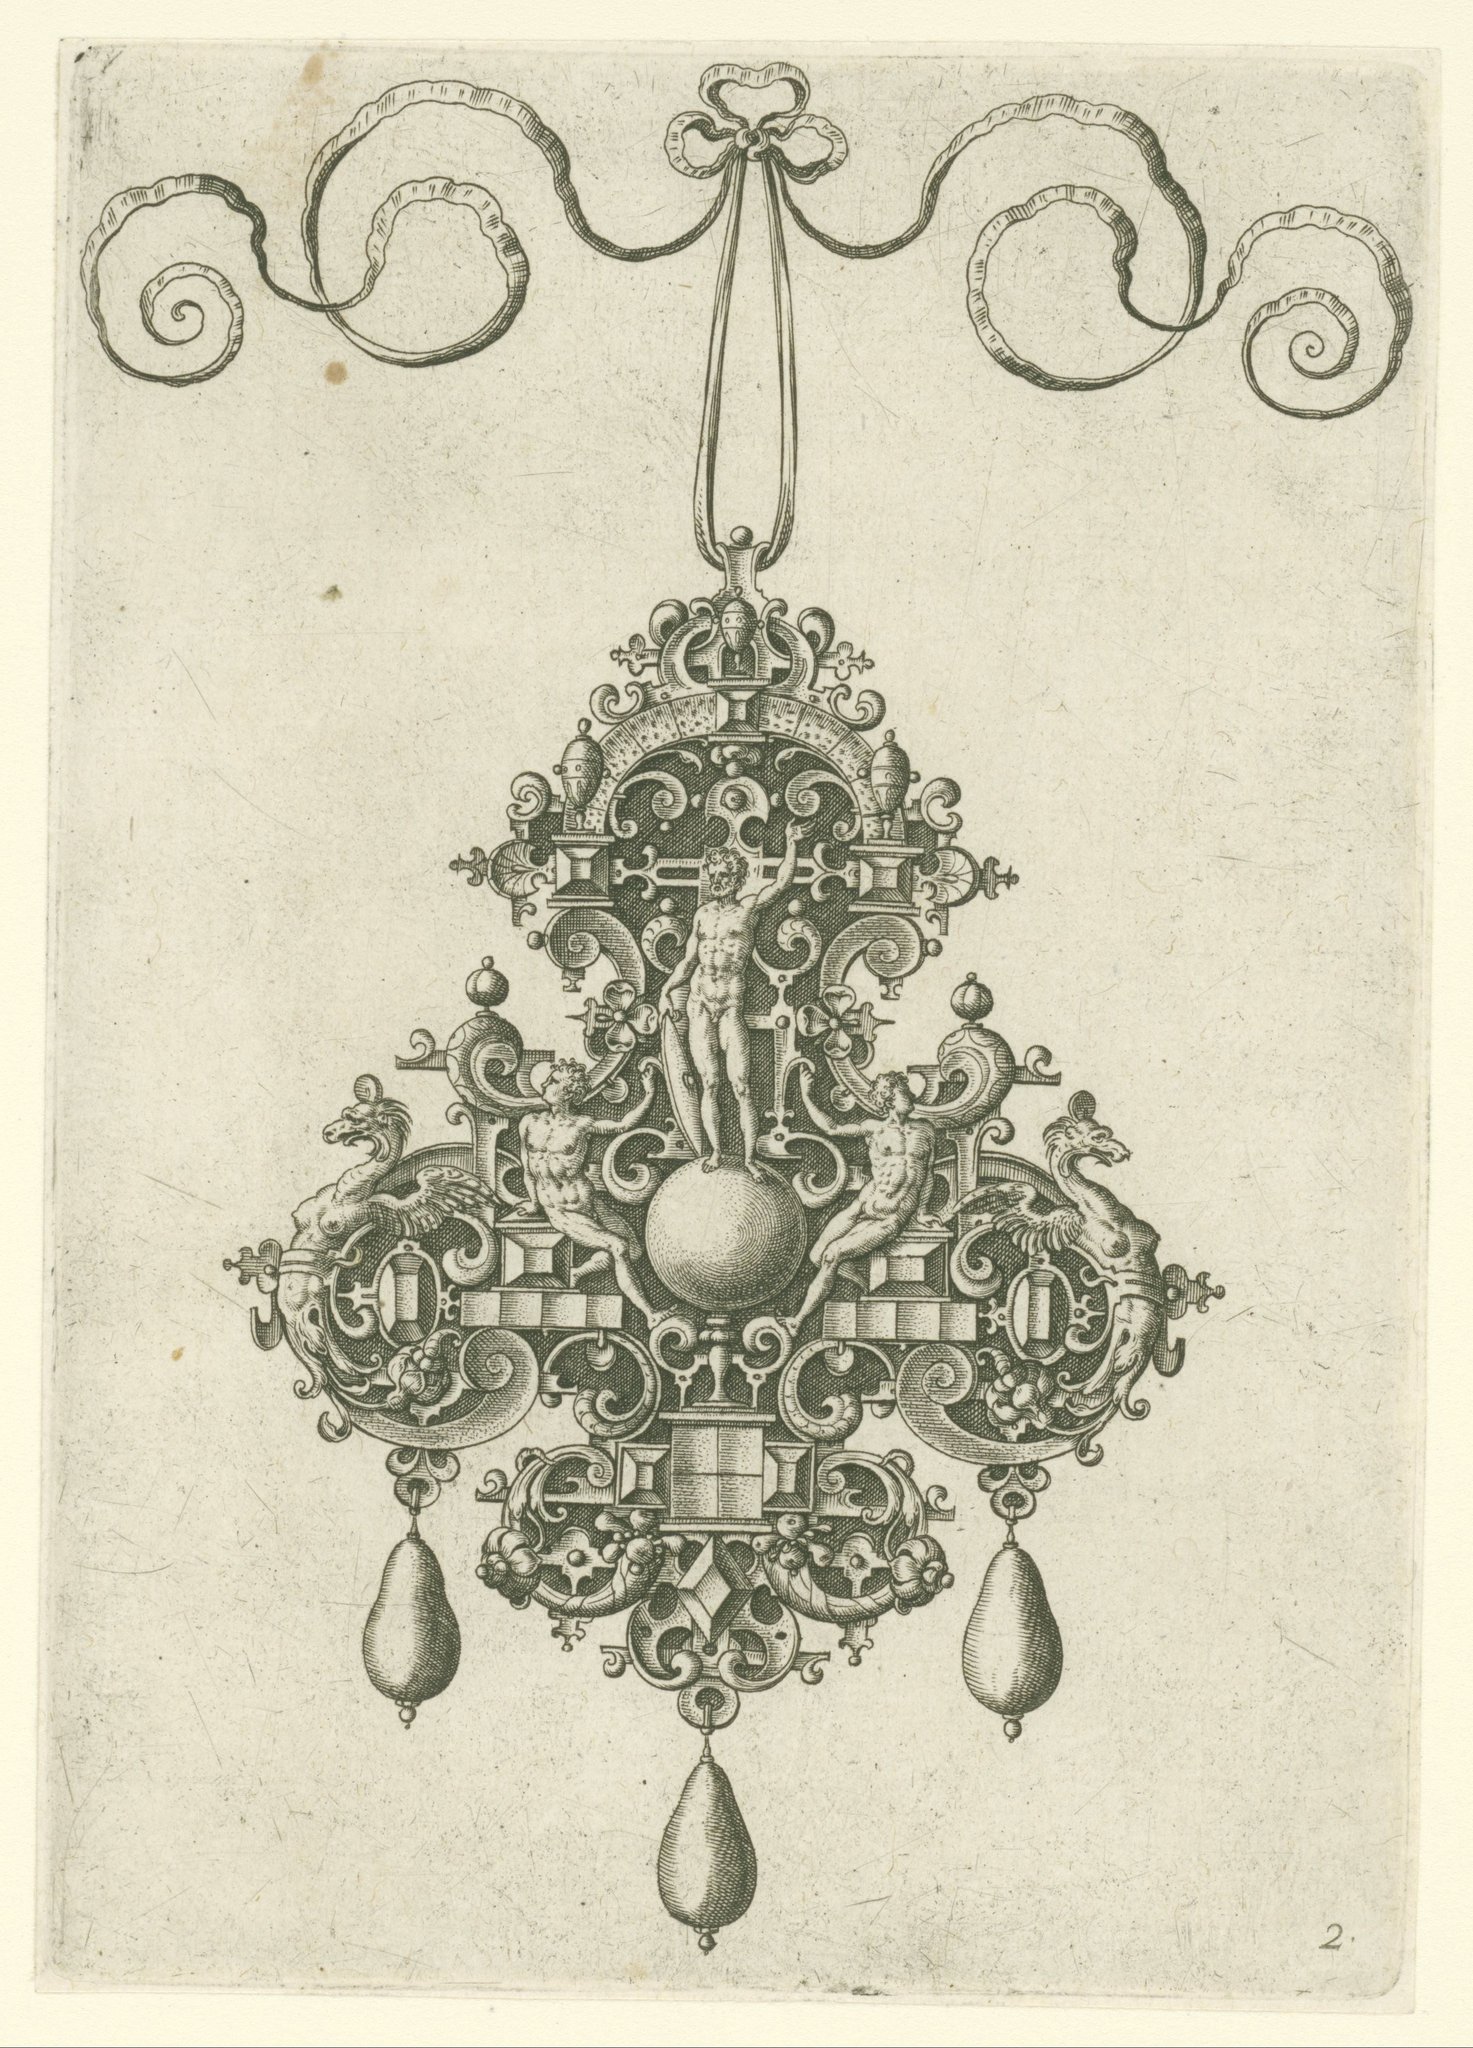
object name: ornament print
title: Voorzijde van hanger met naakte godheid met schild, zittend op een bol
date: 1581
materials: paper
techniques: engraving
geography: netherlands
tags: pendant, trinket, 'breloque'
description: No. 2 uit serie van 10 bladen met voorzijden van hangers. Edelstenen in zettingen van grotesken en rolwerk. Antwerpen 1581. W. 20